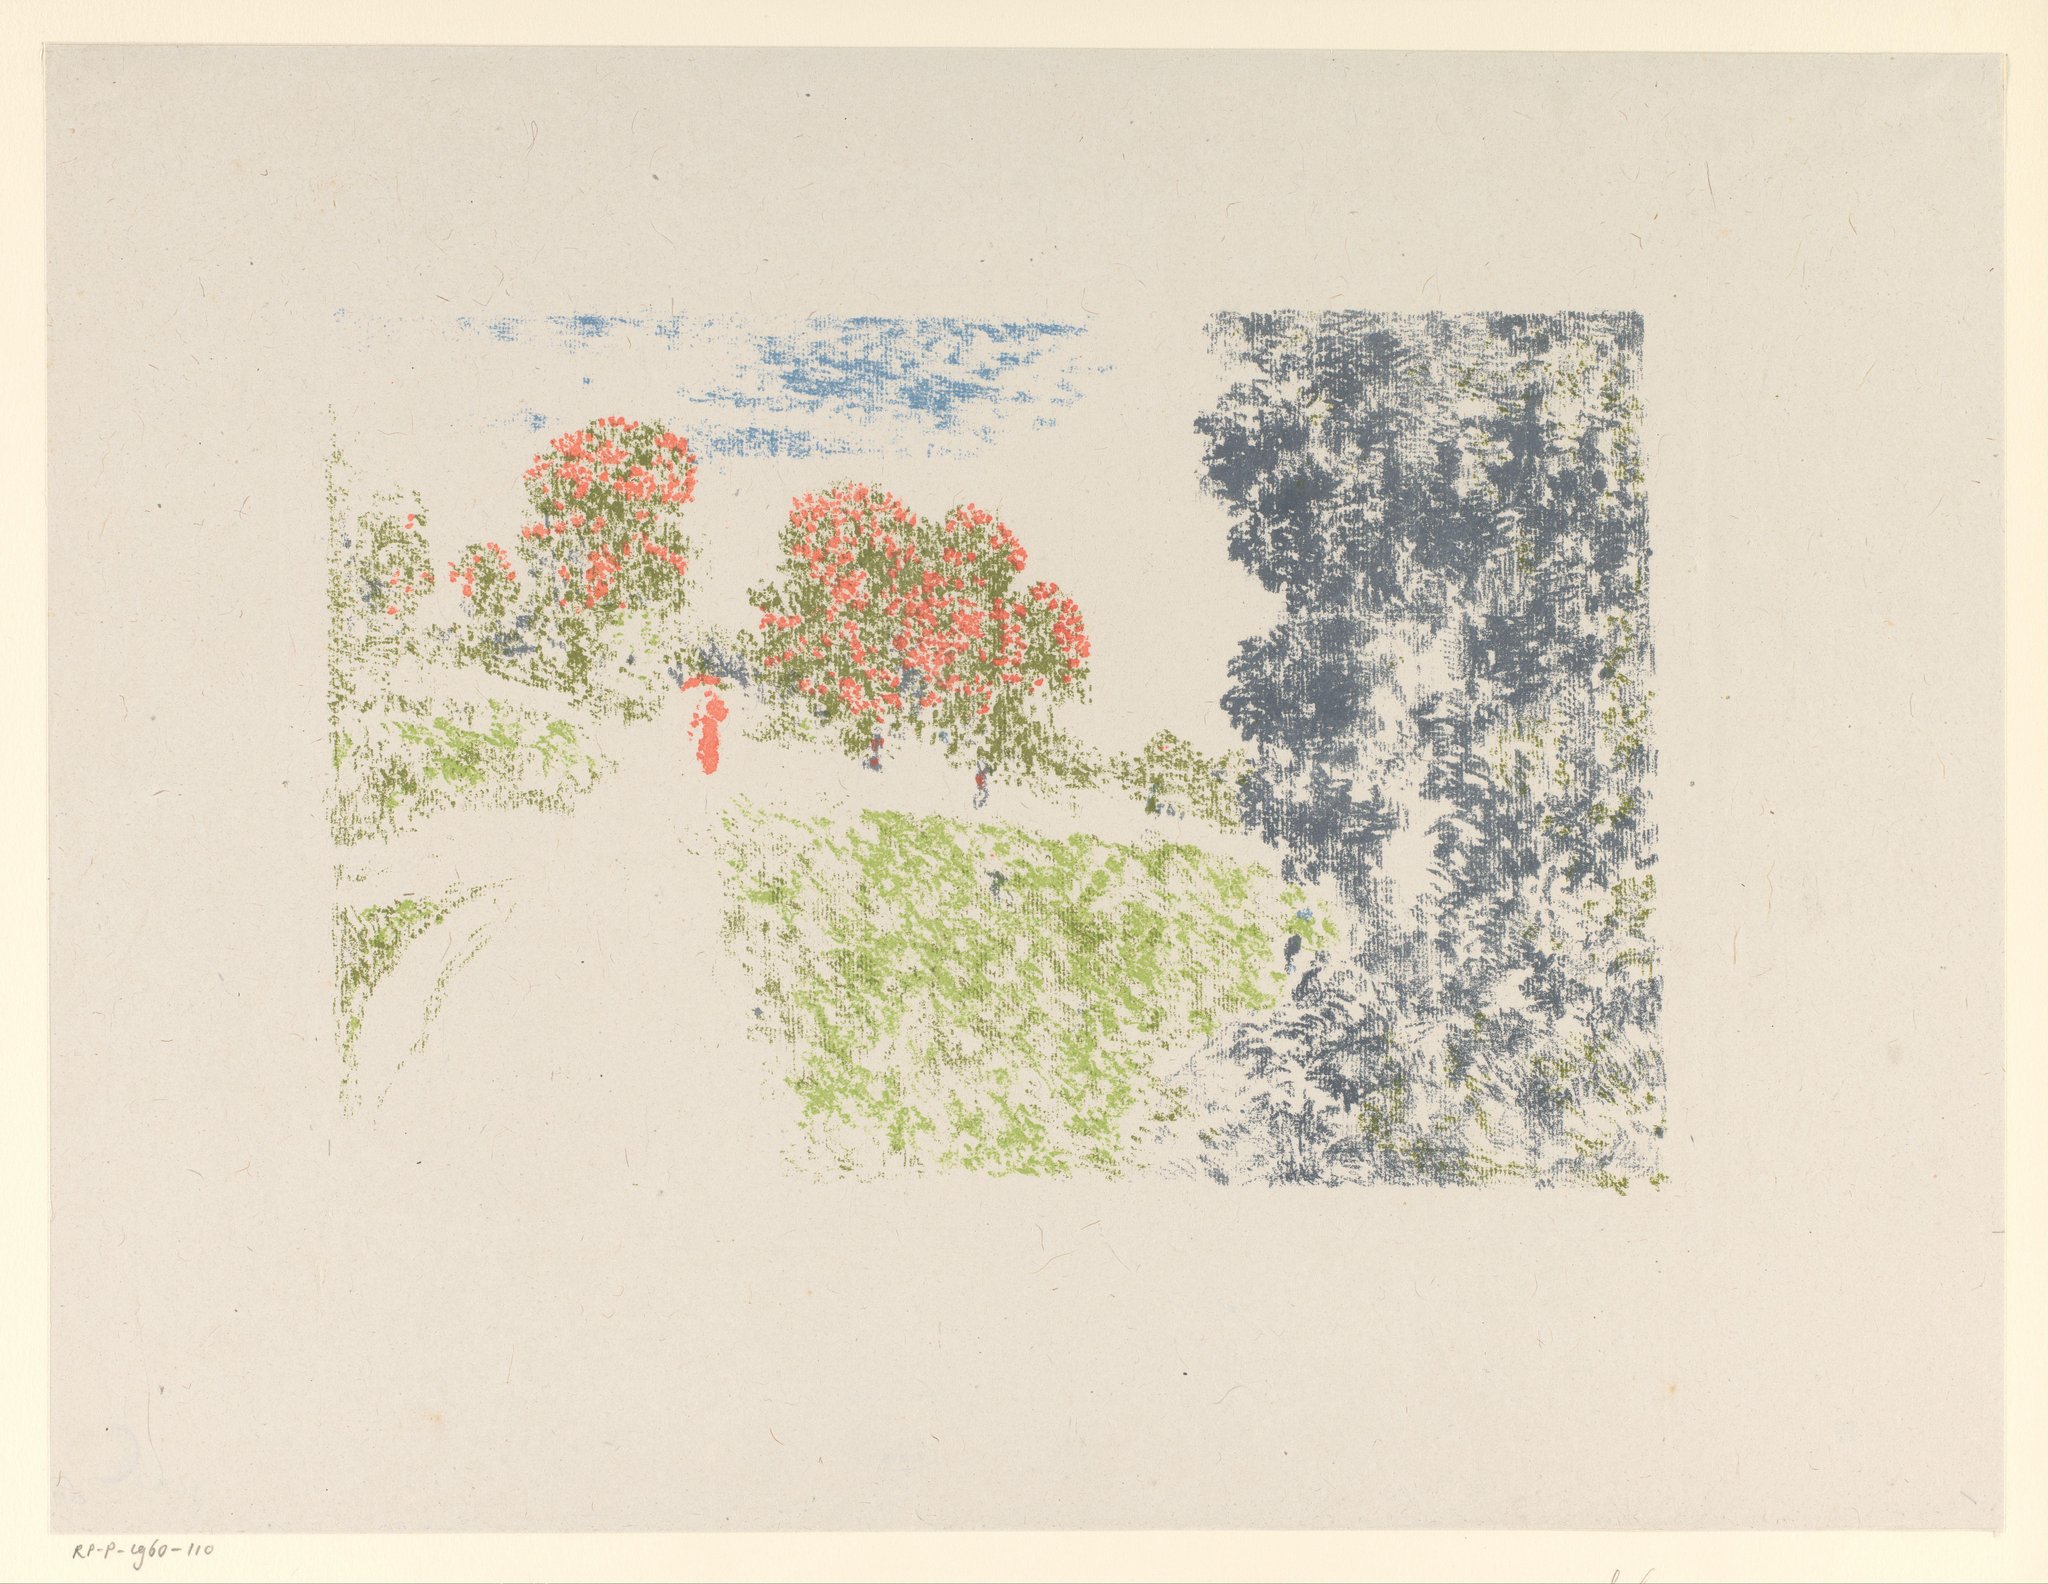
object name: print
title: Femme en rouge dans un paysage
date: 1898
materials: paper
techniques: lithograph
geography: paris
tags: adult woman, landscapes, umbrella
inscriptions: stamp: ‘[...] douanes [...]’, collector's mark: Lugt 2760, inscription: ‘34167 [...]’, collector's mark: Lugt 2228